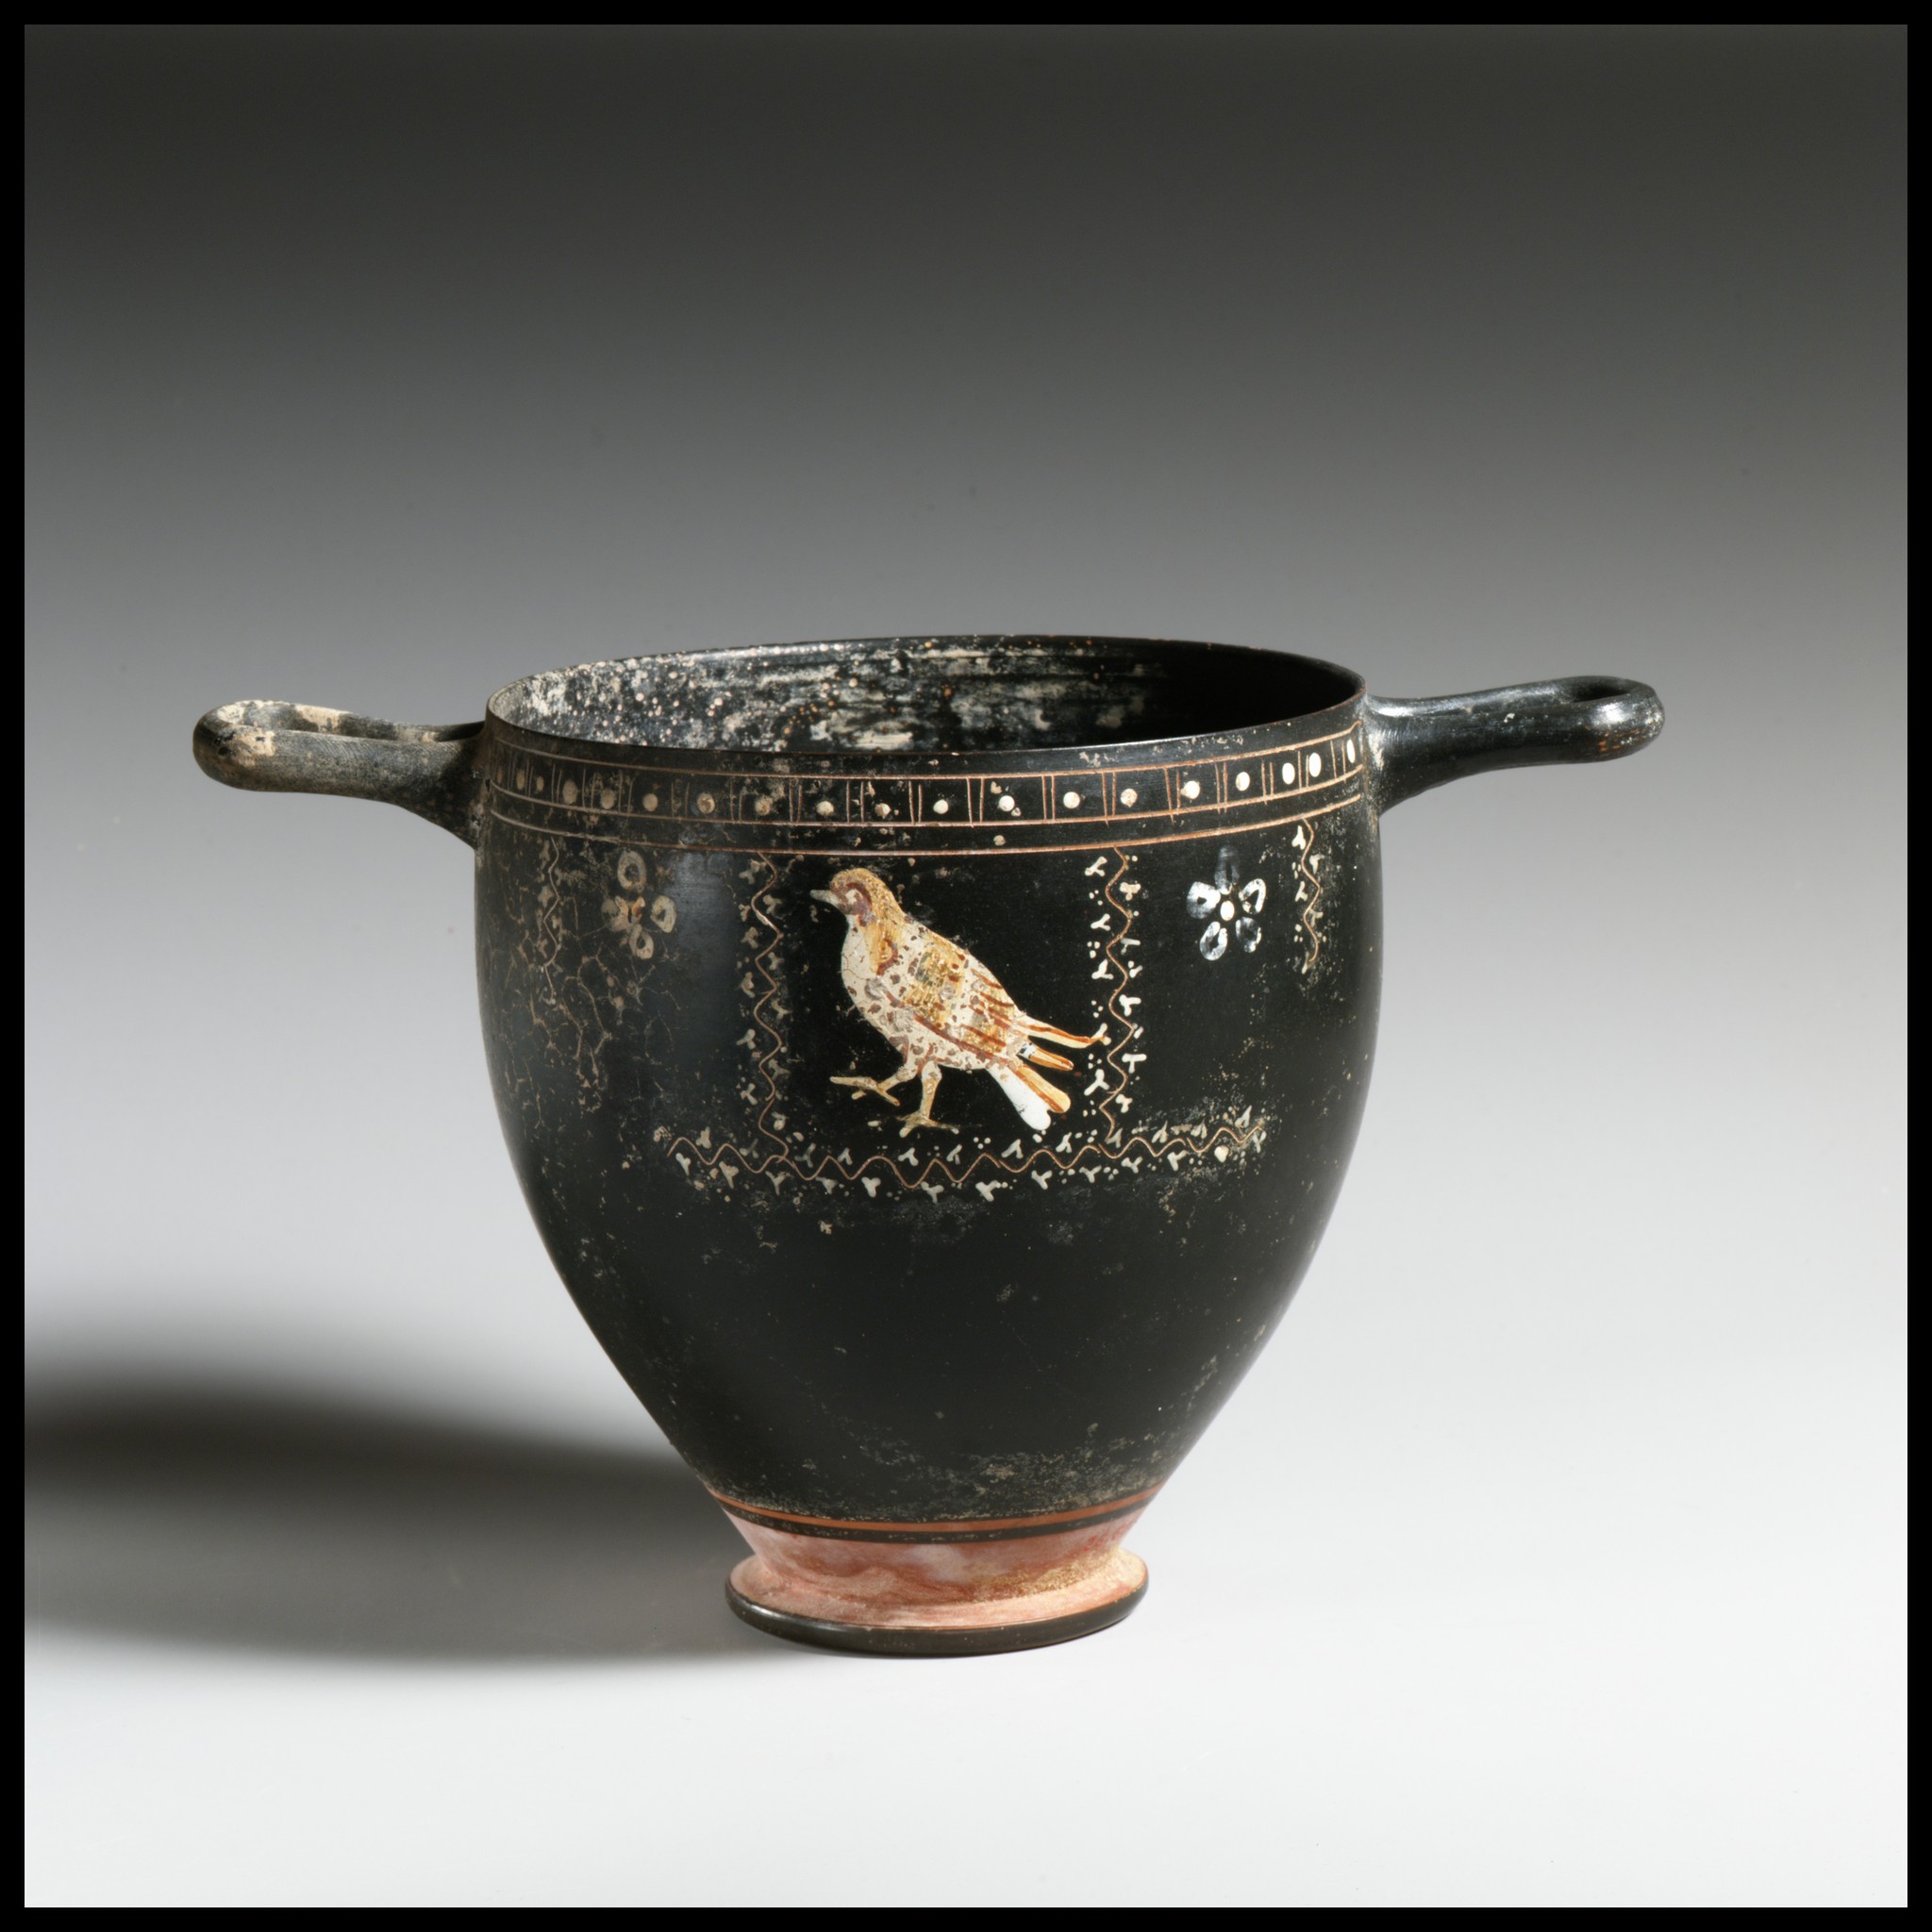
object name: skyphos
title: Terracotta skyphos (deep drinking cup)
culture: greek, south italian, apulian, gnathian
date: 350-325 BCE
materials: terracotta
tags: birds